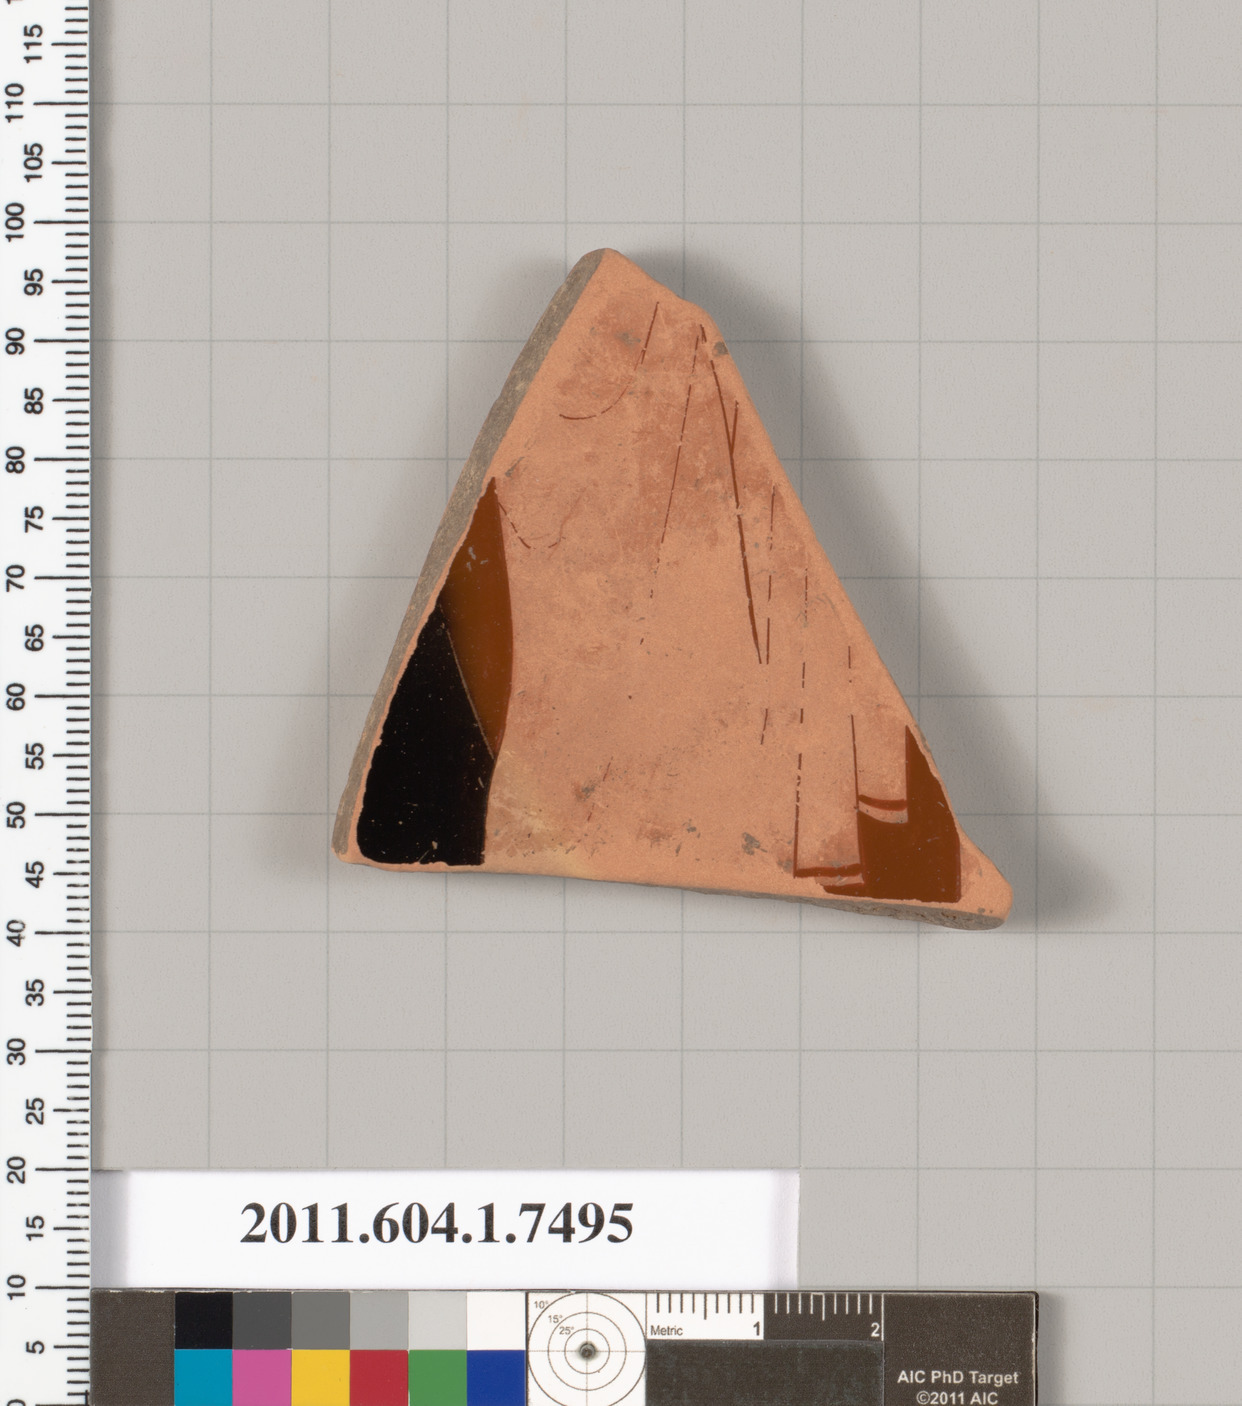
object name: kylix fragment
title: Terracotta fragment of a kylix (drinking cup)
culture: greek, attic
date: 460-450 BCE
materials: terracotta